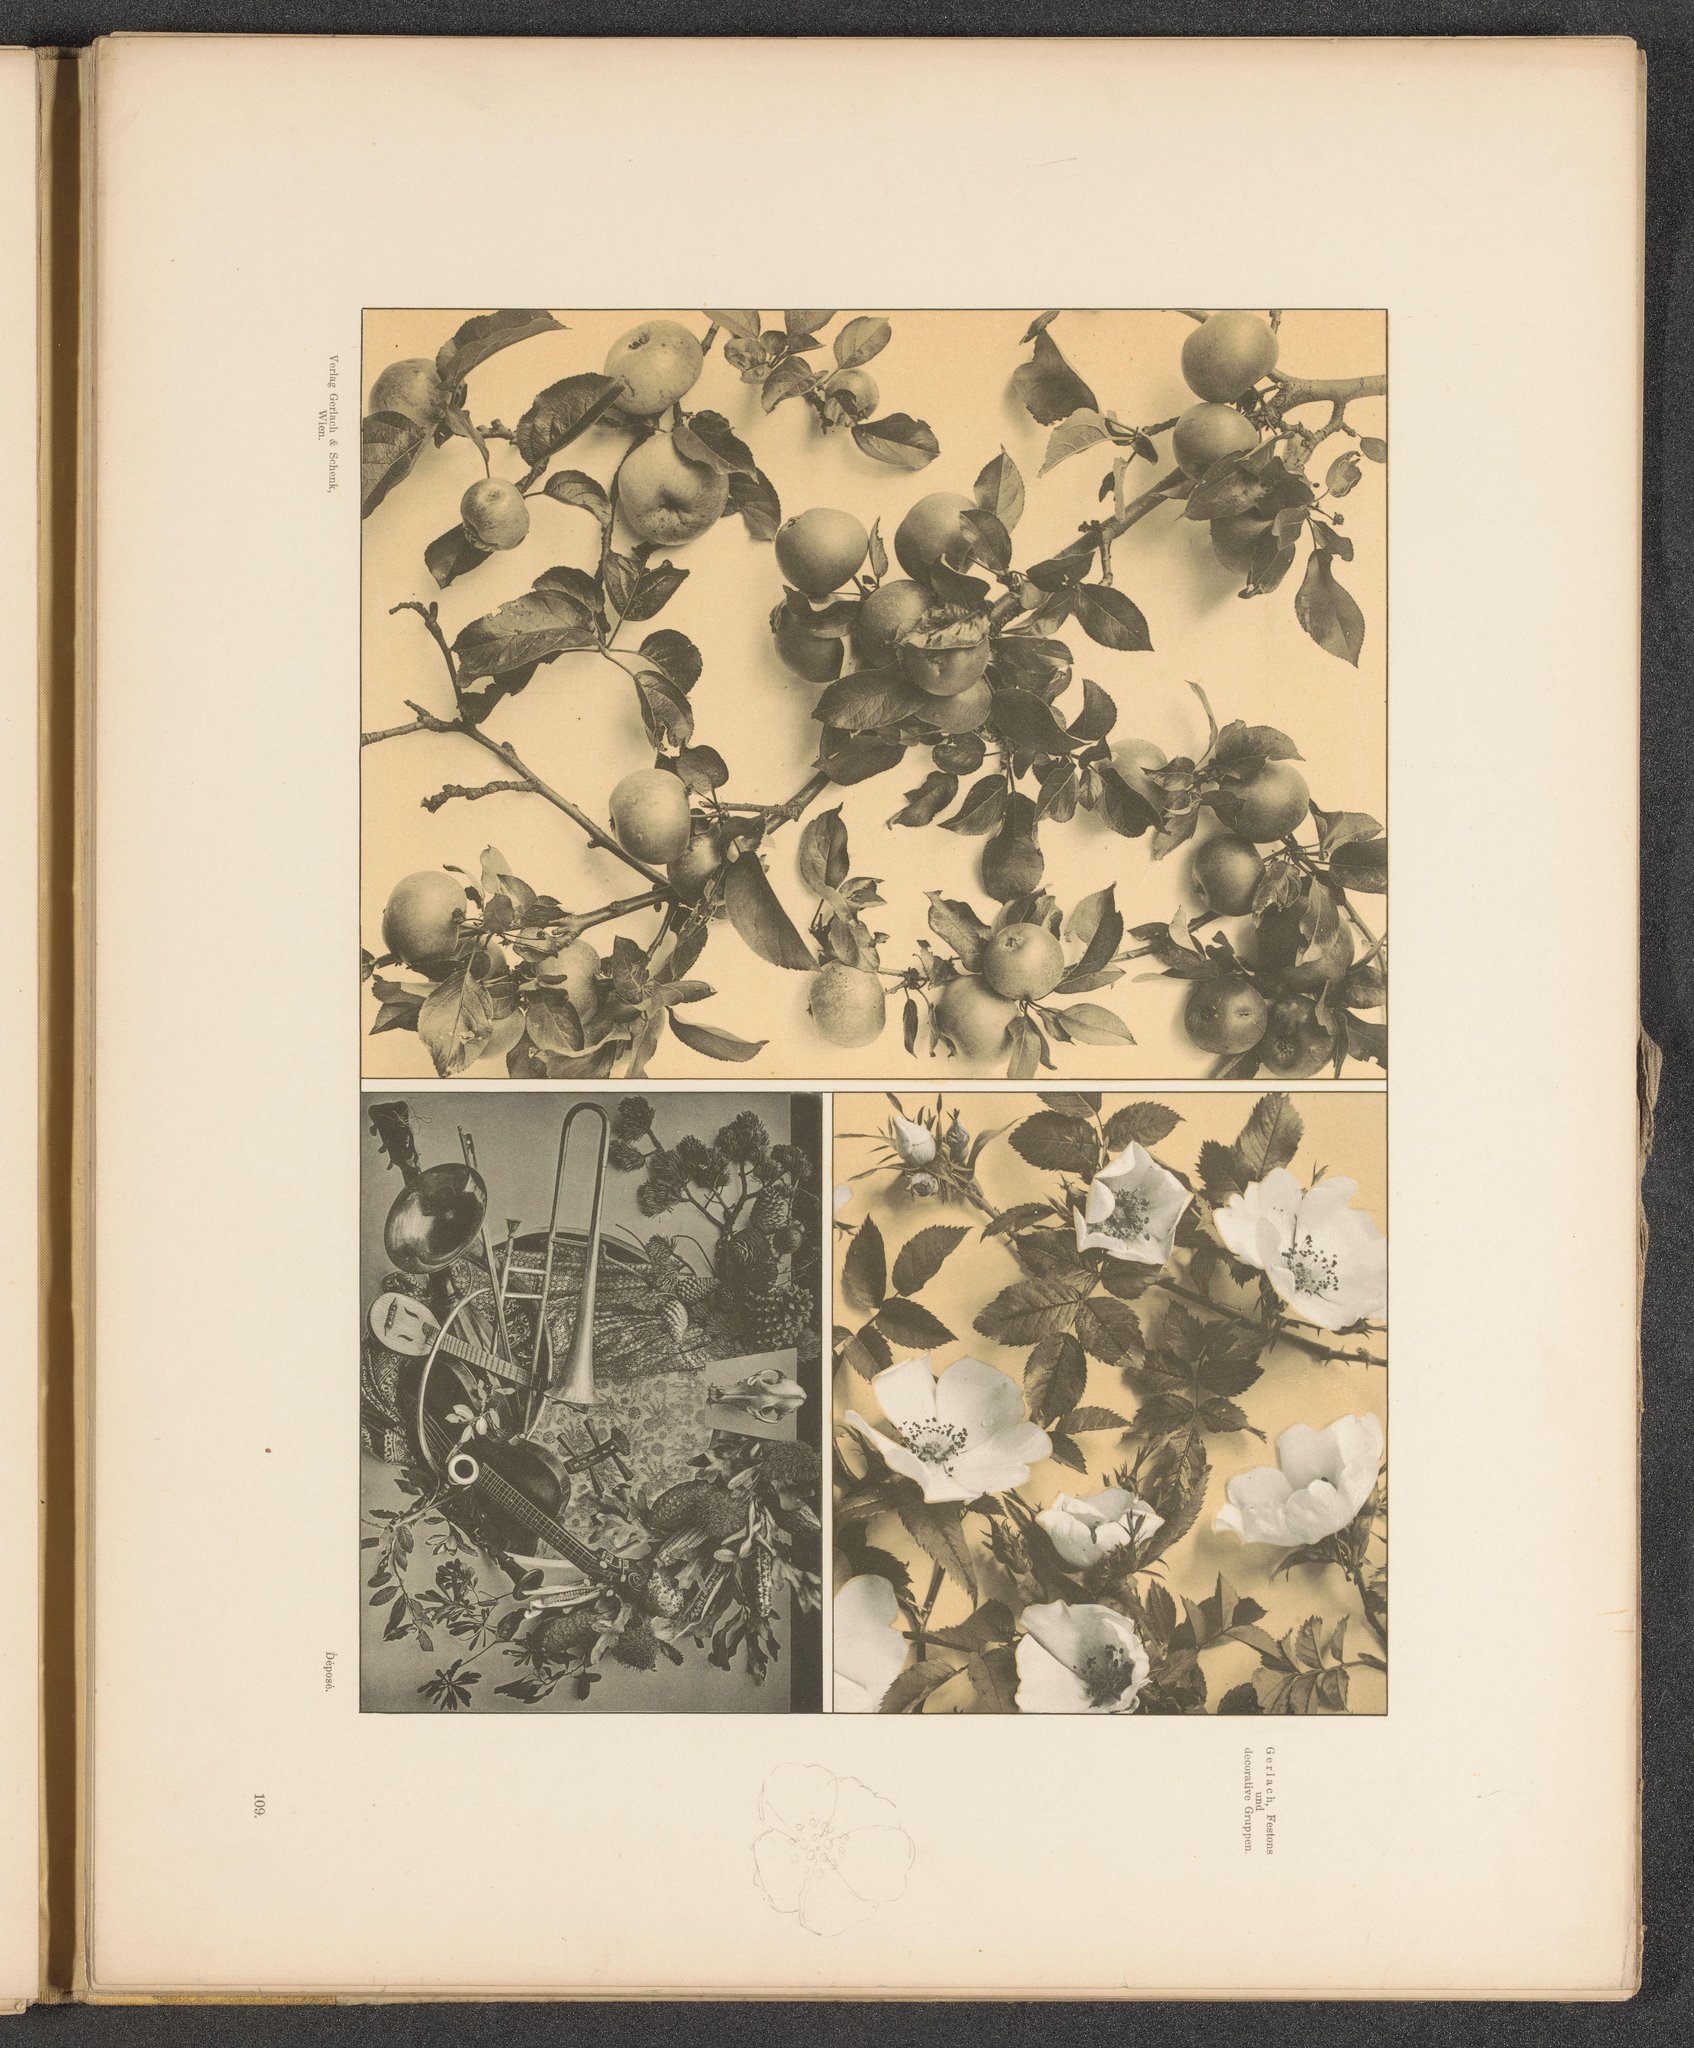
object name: photomechanical print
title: Vlakken met heggenrozen, appelboomtakken en een festoen met muziekinstrumenten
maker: Anonymous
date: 1887-1897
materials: paper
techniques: photograph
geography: austria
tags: musical instruments; group of musical instruments, trees: apple-tree (branch, stick)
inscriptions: number: ‘109.’